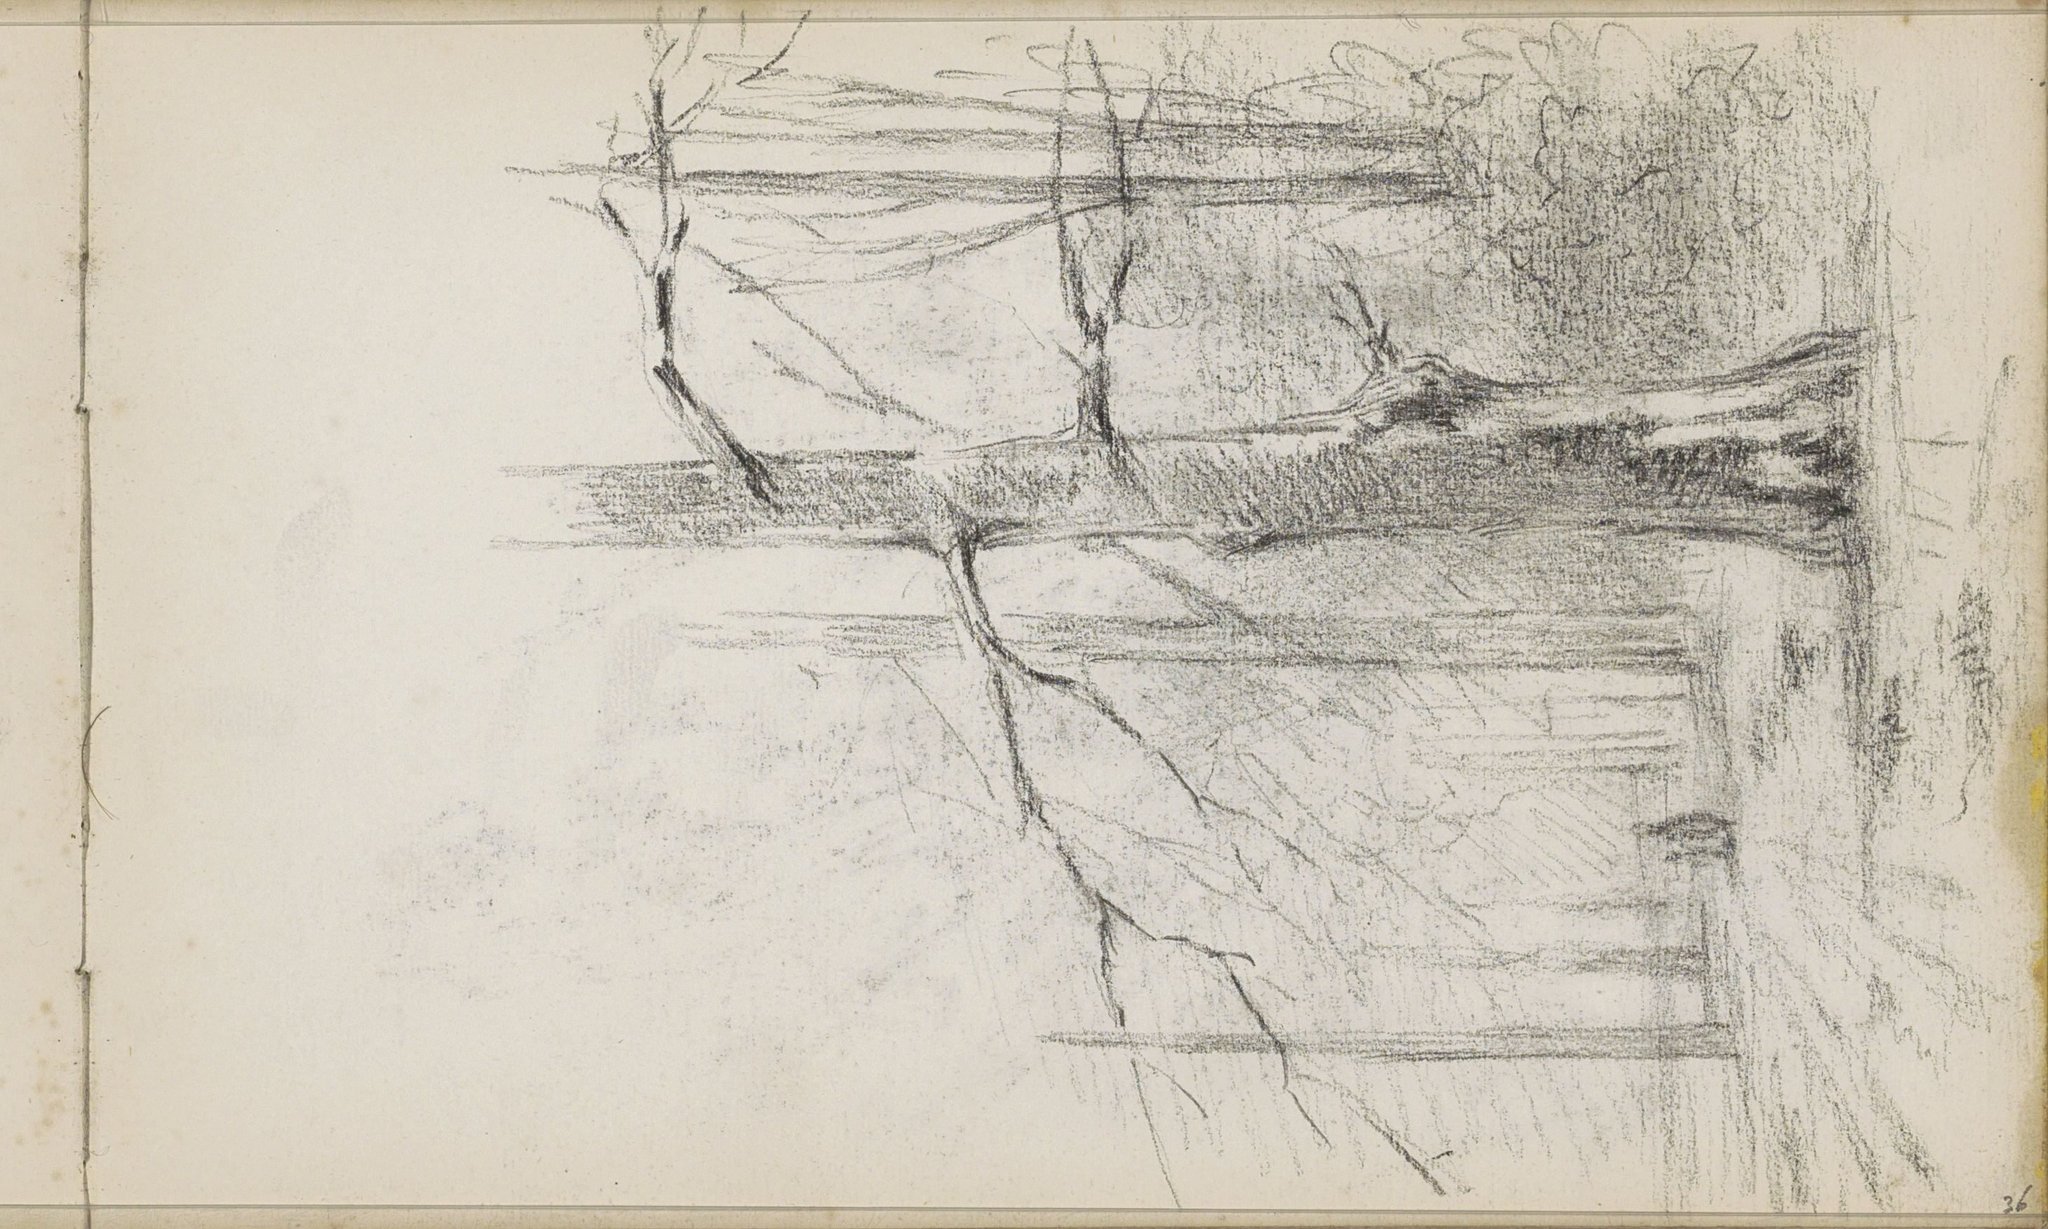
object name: sketchbook leaf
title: Figuren op een bomenlaan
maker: willem cornelis rip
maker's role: draughtsman, painter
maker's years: 1856-1922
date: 1876-1877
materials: chalk, paper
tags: forest path or lane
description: Blad 36 recto uit een schetsboek met 41 bladen.